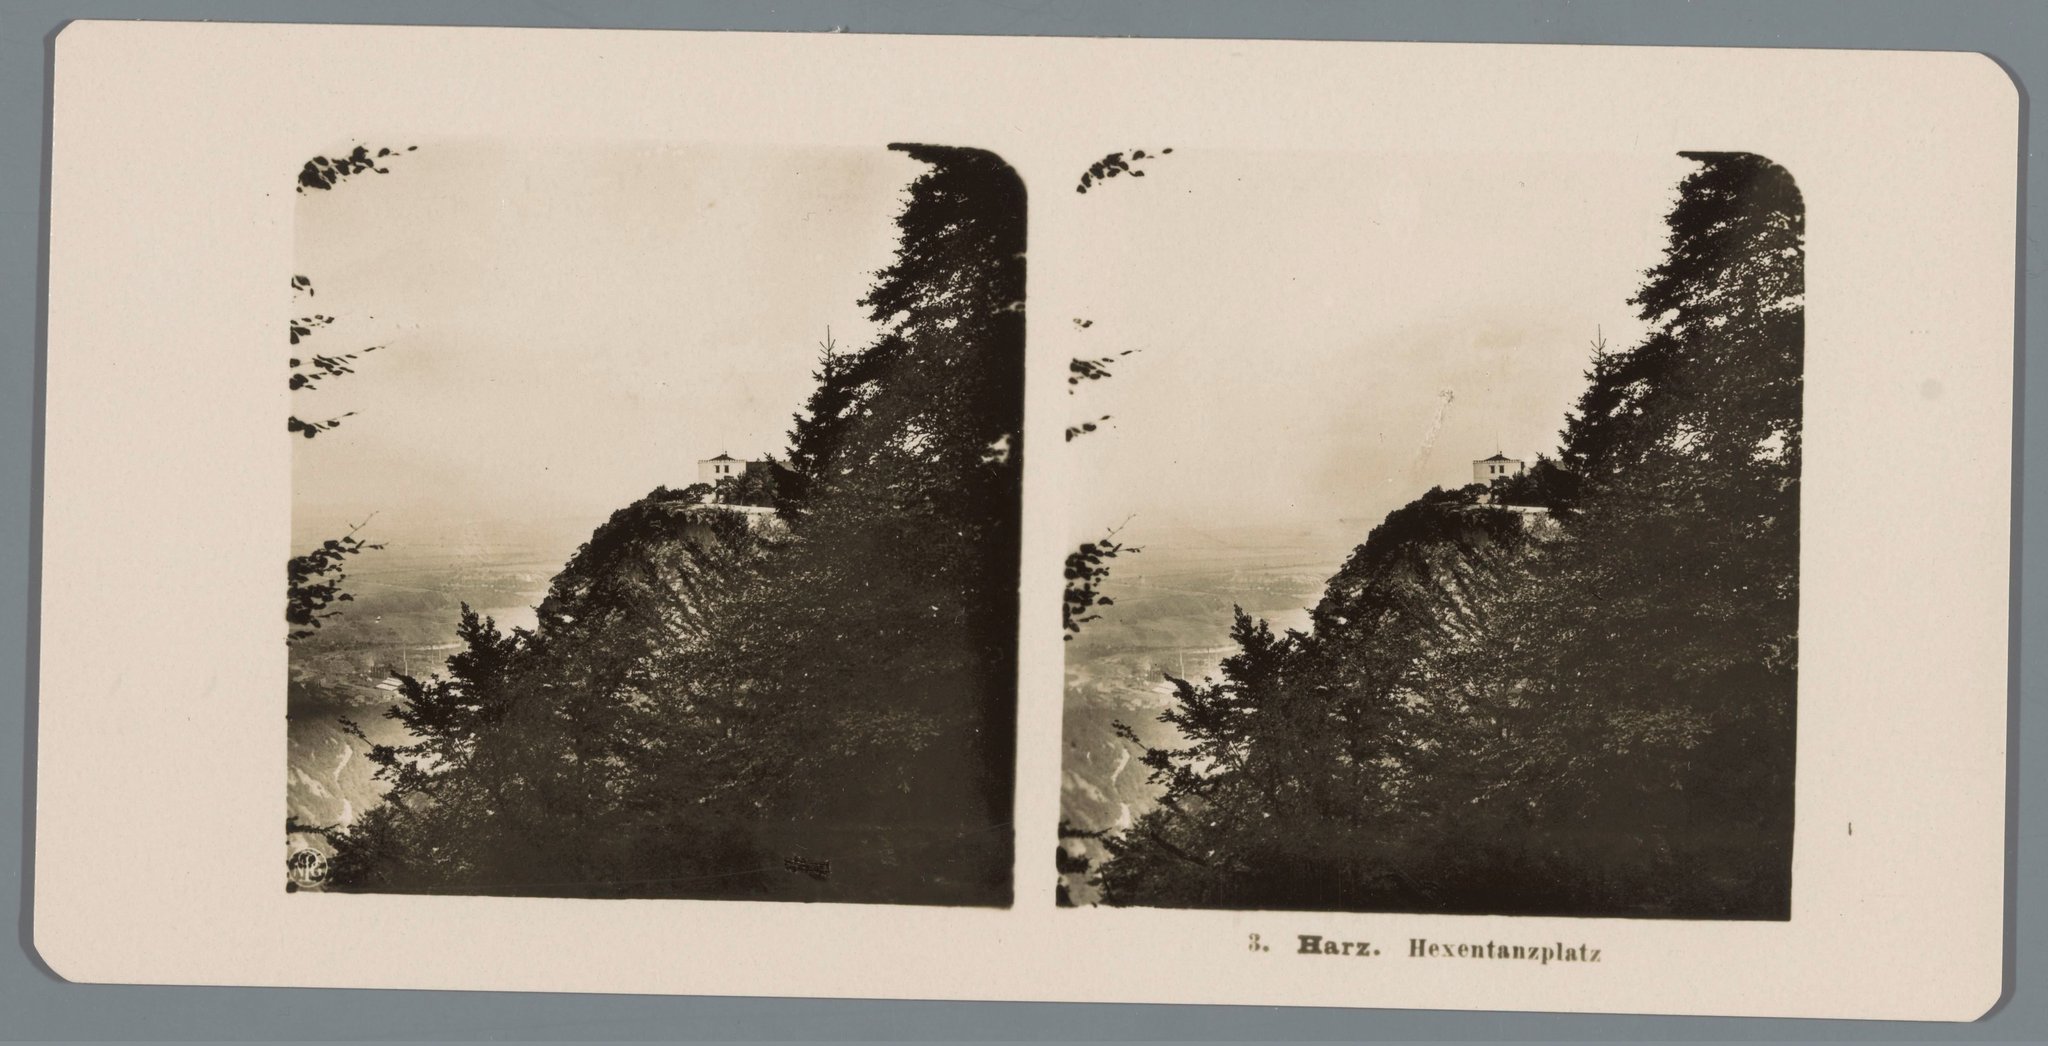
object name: stereograph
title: Harz. Hexentanzplatz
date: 1900-1910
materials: cardboard, photographic support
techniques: gelatin silver print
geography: harz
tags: mountain-top, peak, mountains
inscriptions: inscription: ‘NPG’, number: ‘3.’